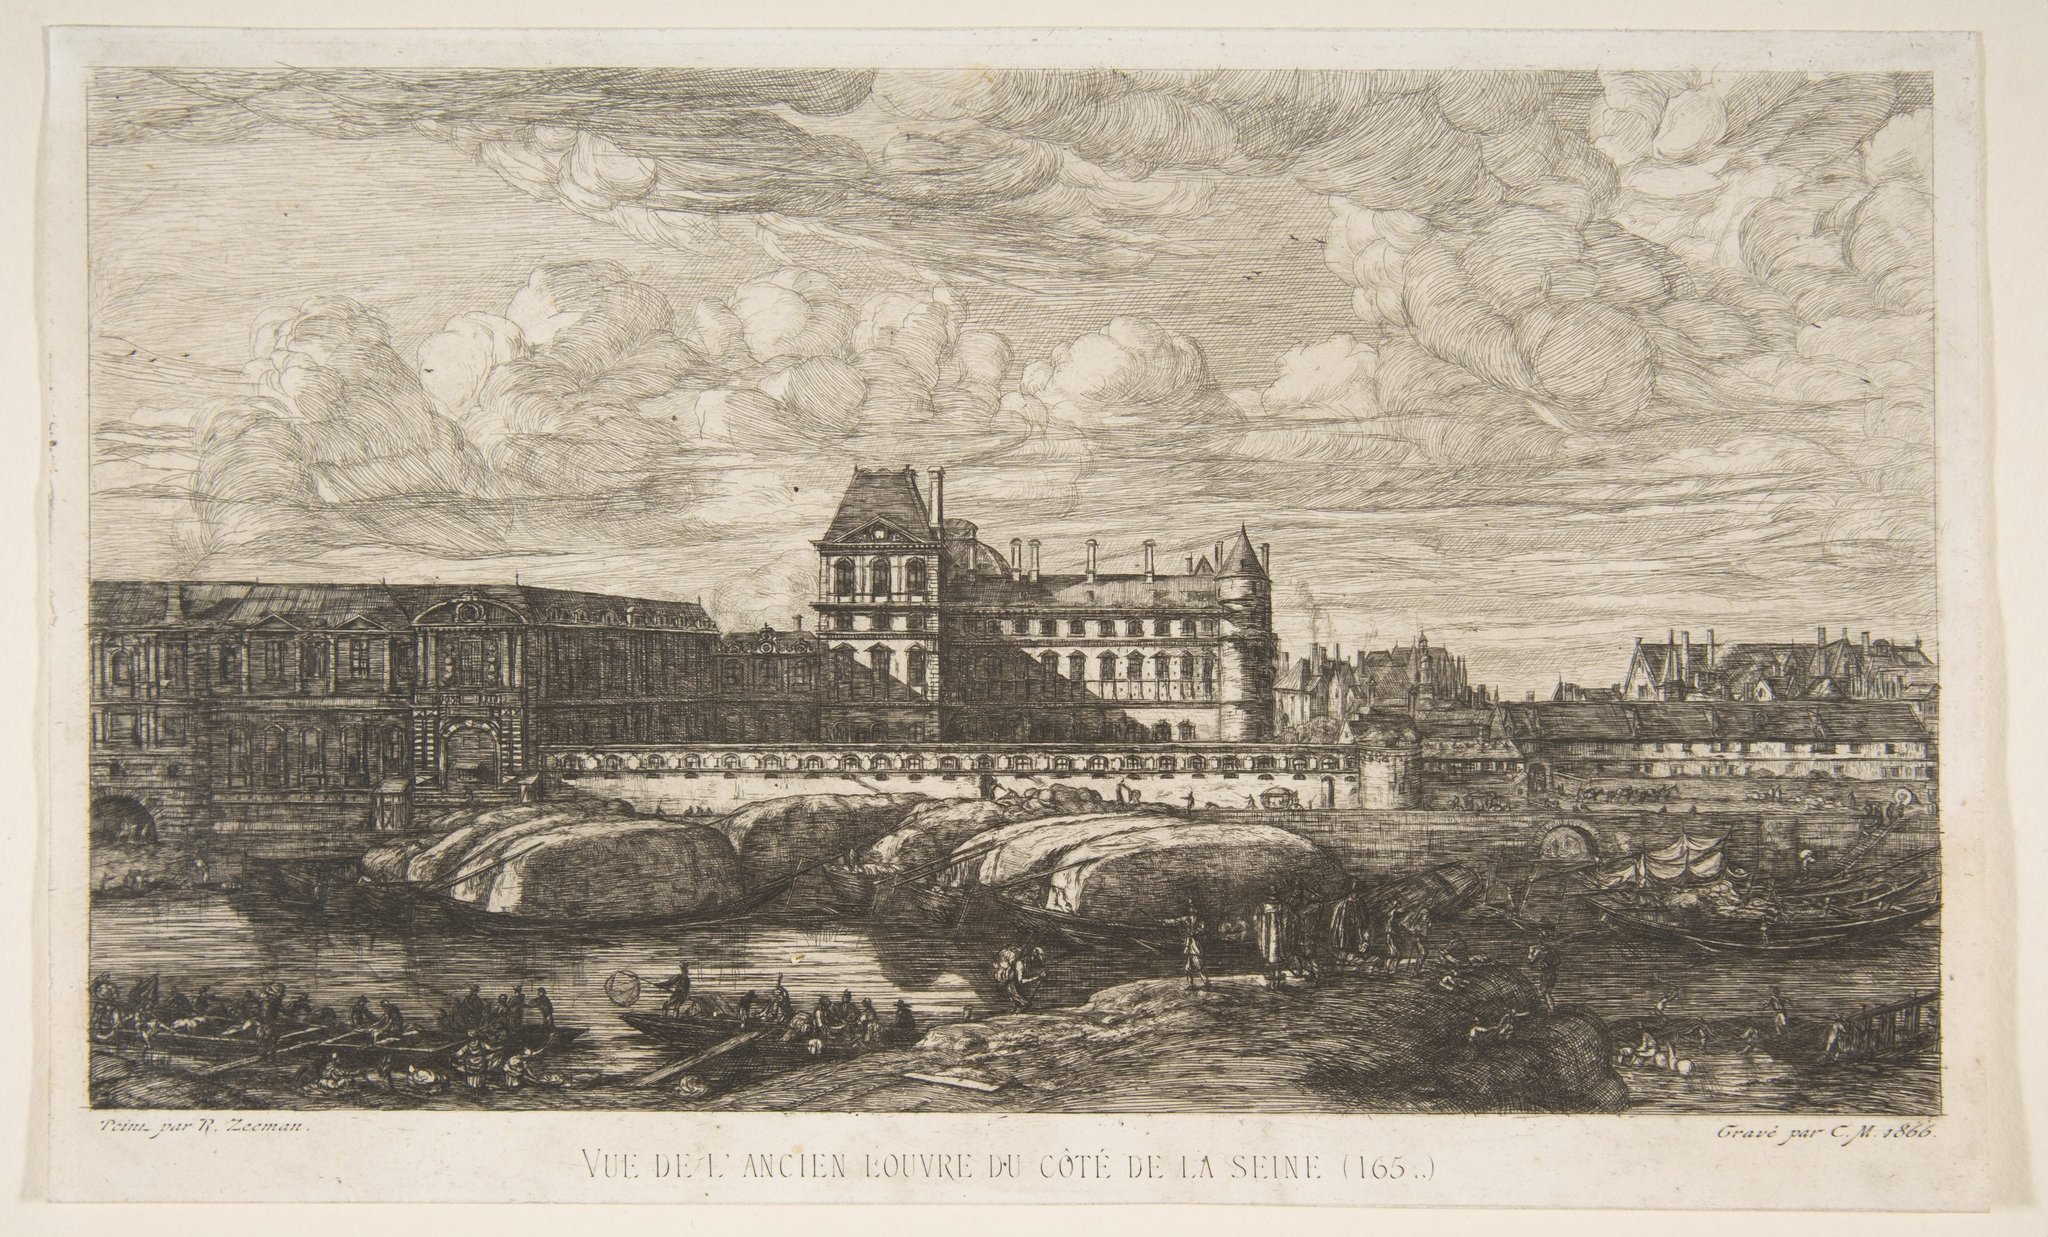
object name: print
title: The Old Louvre, Paris, after Zeeman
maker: charles meryon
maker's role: artist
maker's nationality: french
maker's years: 1821-1868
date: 1865-1866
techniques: etching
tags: buildings,cities,boats,paris